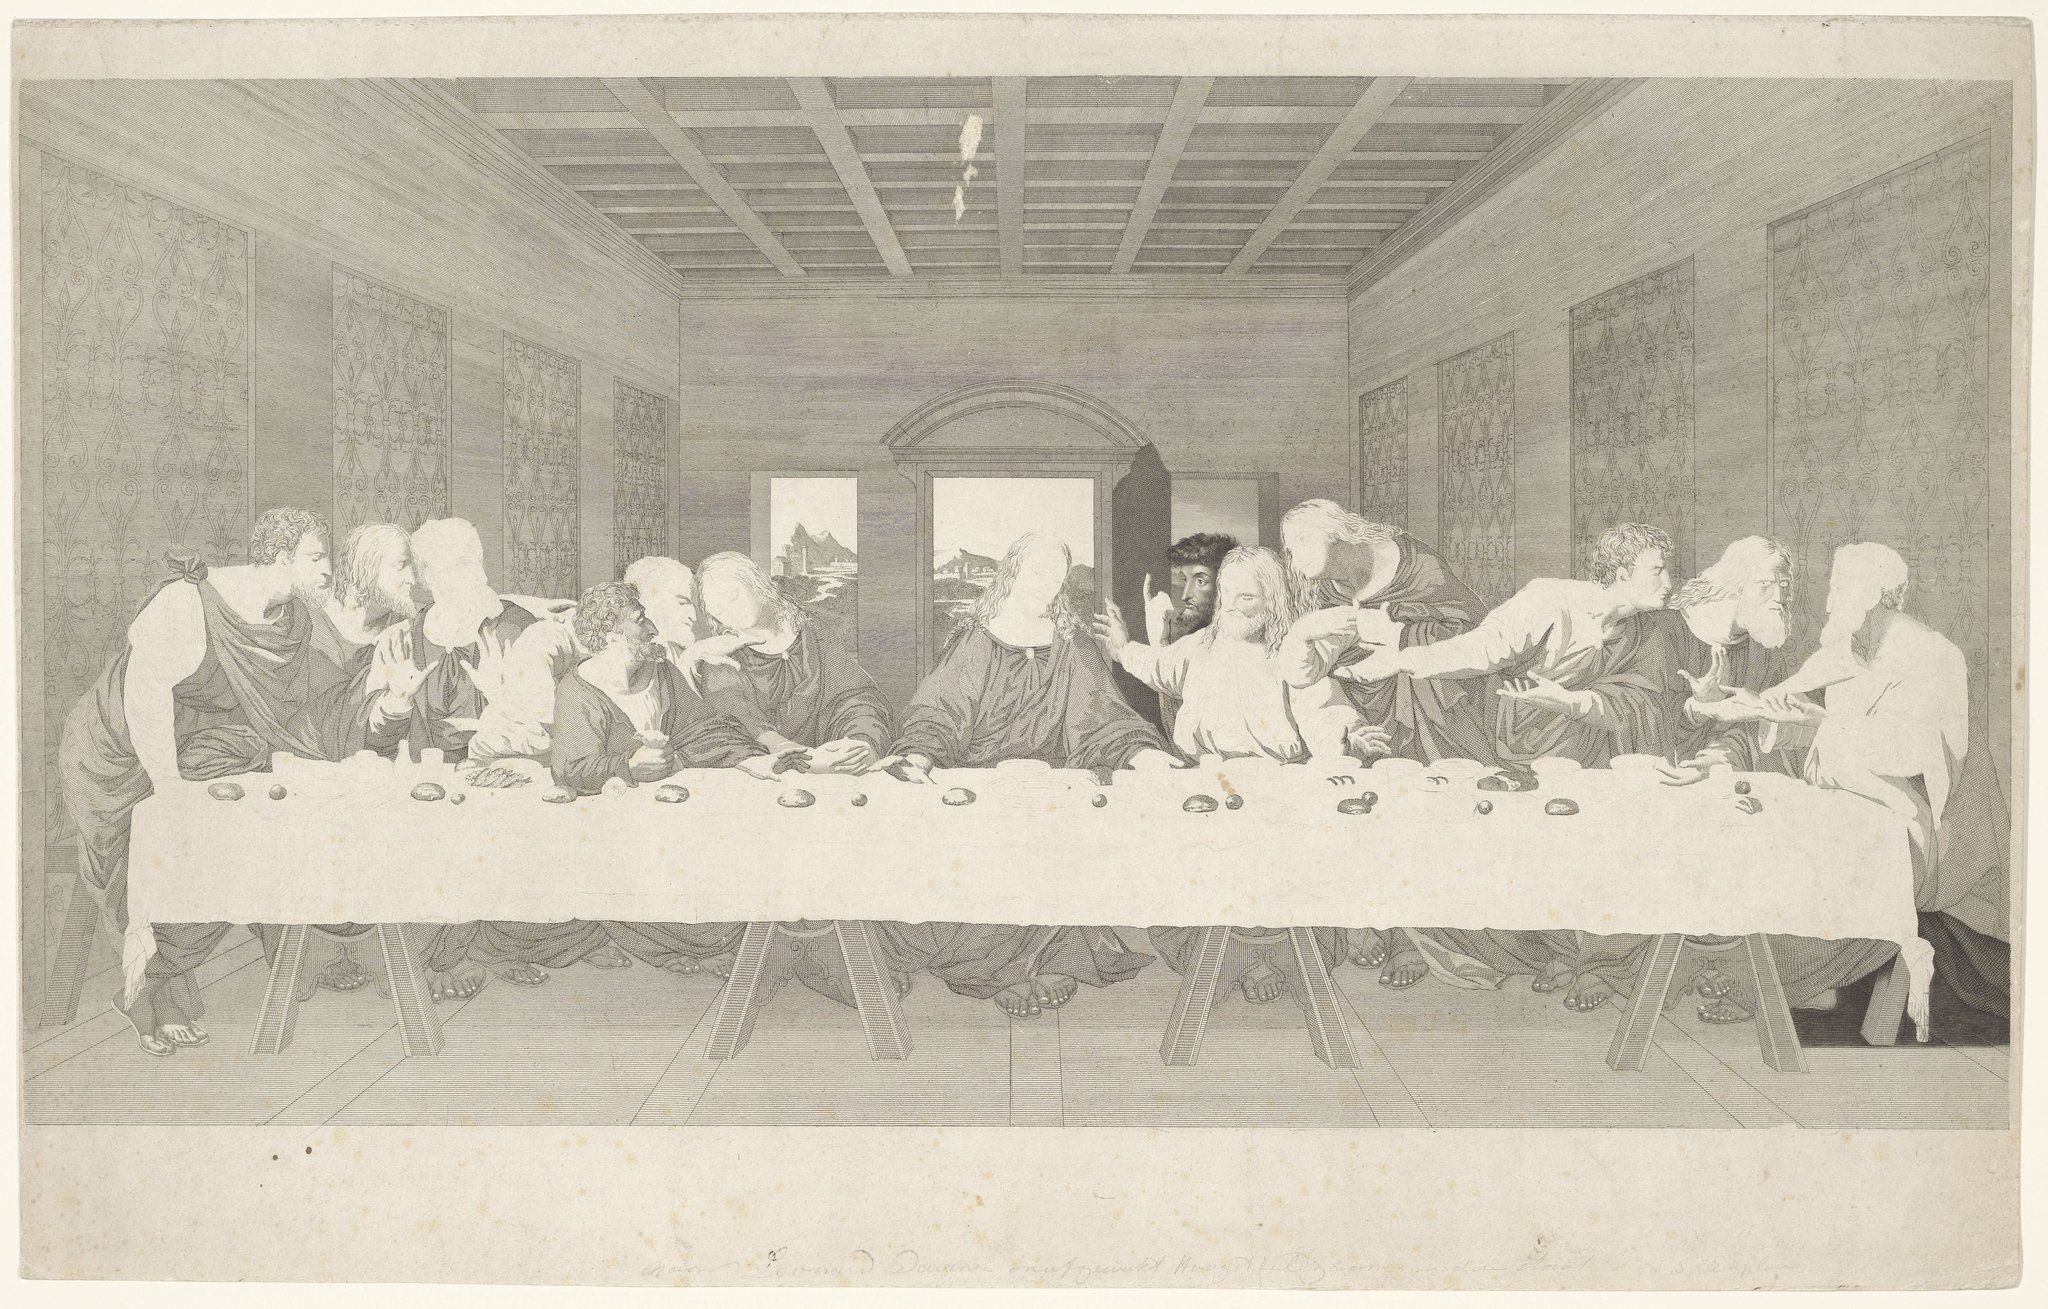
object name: print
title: Het laatste avondmaal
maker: raphael morghen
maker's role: draughtsman, painter, print maker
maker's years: 1758-1833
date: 1768-1833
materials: paper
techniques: engraving, etching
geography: italy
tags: last supper (in general) (matthew 26:21-35; mark 14:18-31; luke 22:3, 22:15-23; john 13:21-38)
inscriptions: collector's mark: Lugt 2228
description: Het fresco 'Het laatste avondmaal' door Leonardo Da Vinci met Christus tussen de apostelen aan een lange tafel.